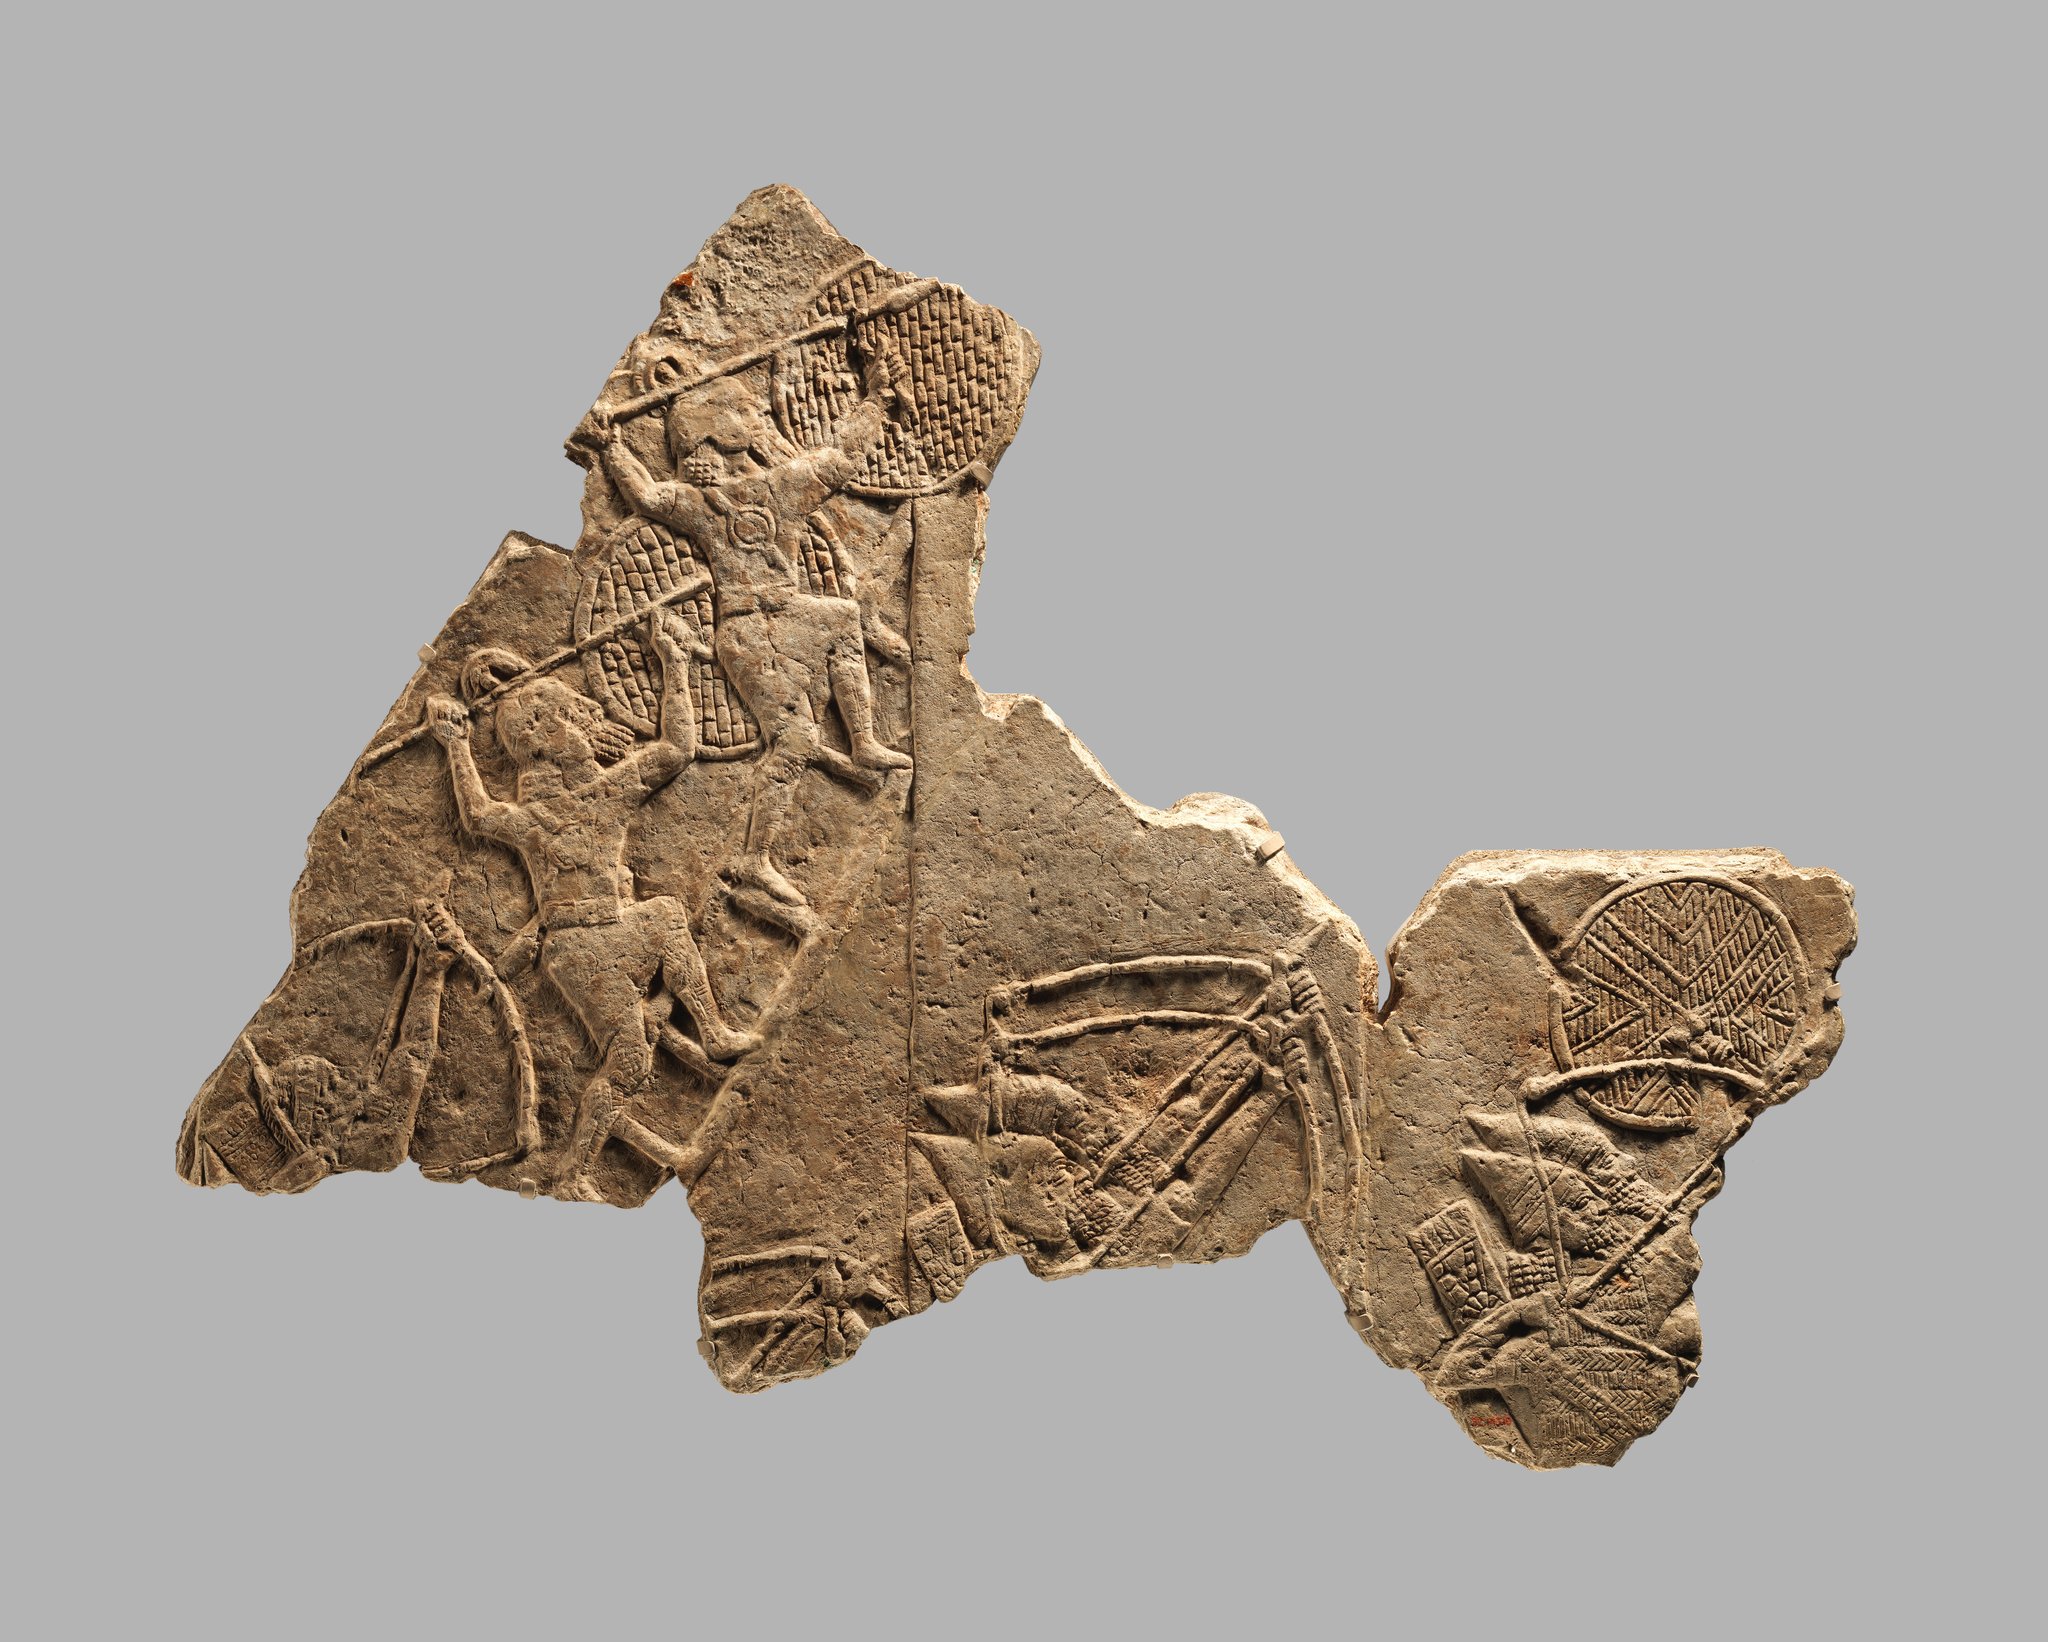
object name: relief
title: Relief fragment: siege of a city by Assyrian troops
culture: assyrian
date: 704-681 BCE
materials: alabaster, gypsum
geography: mesopotamia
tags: bow and arrow,shields,spears,men